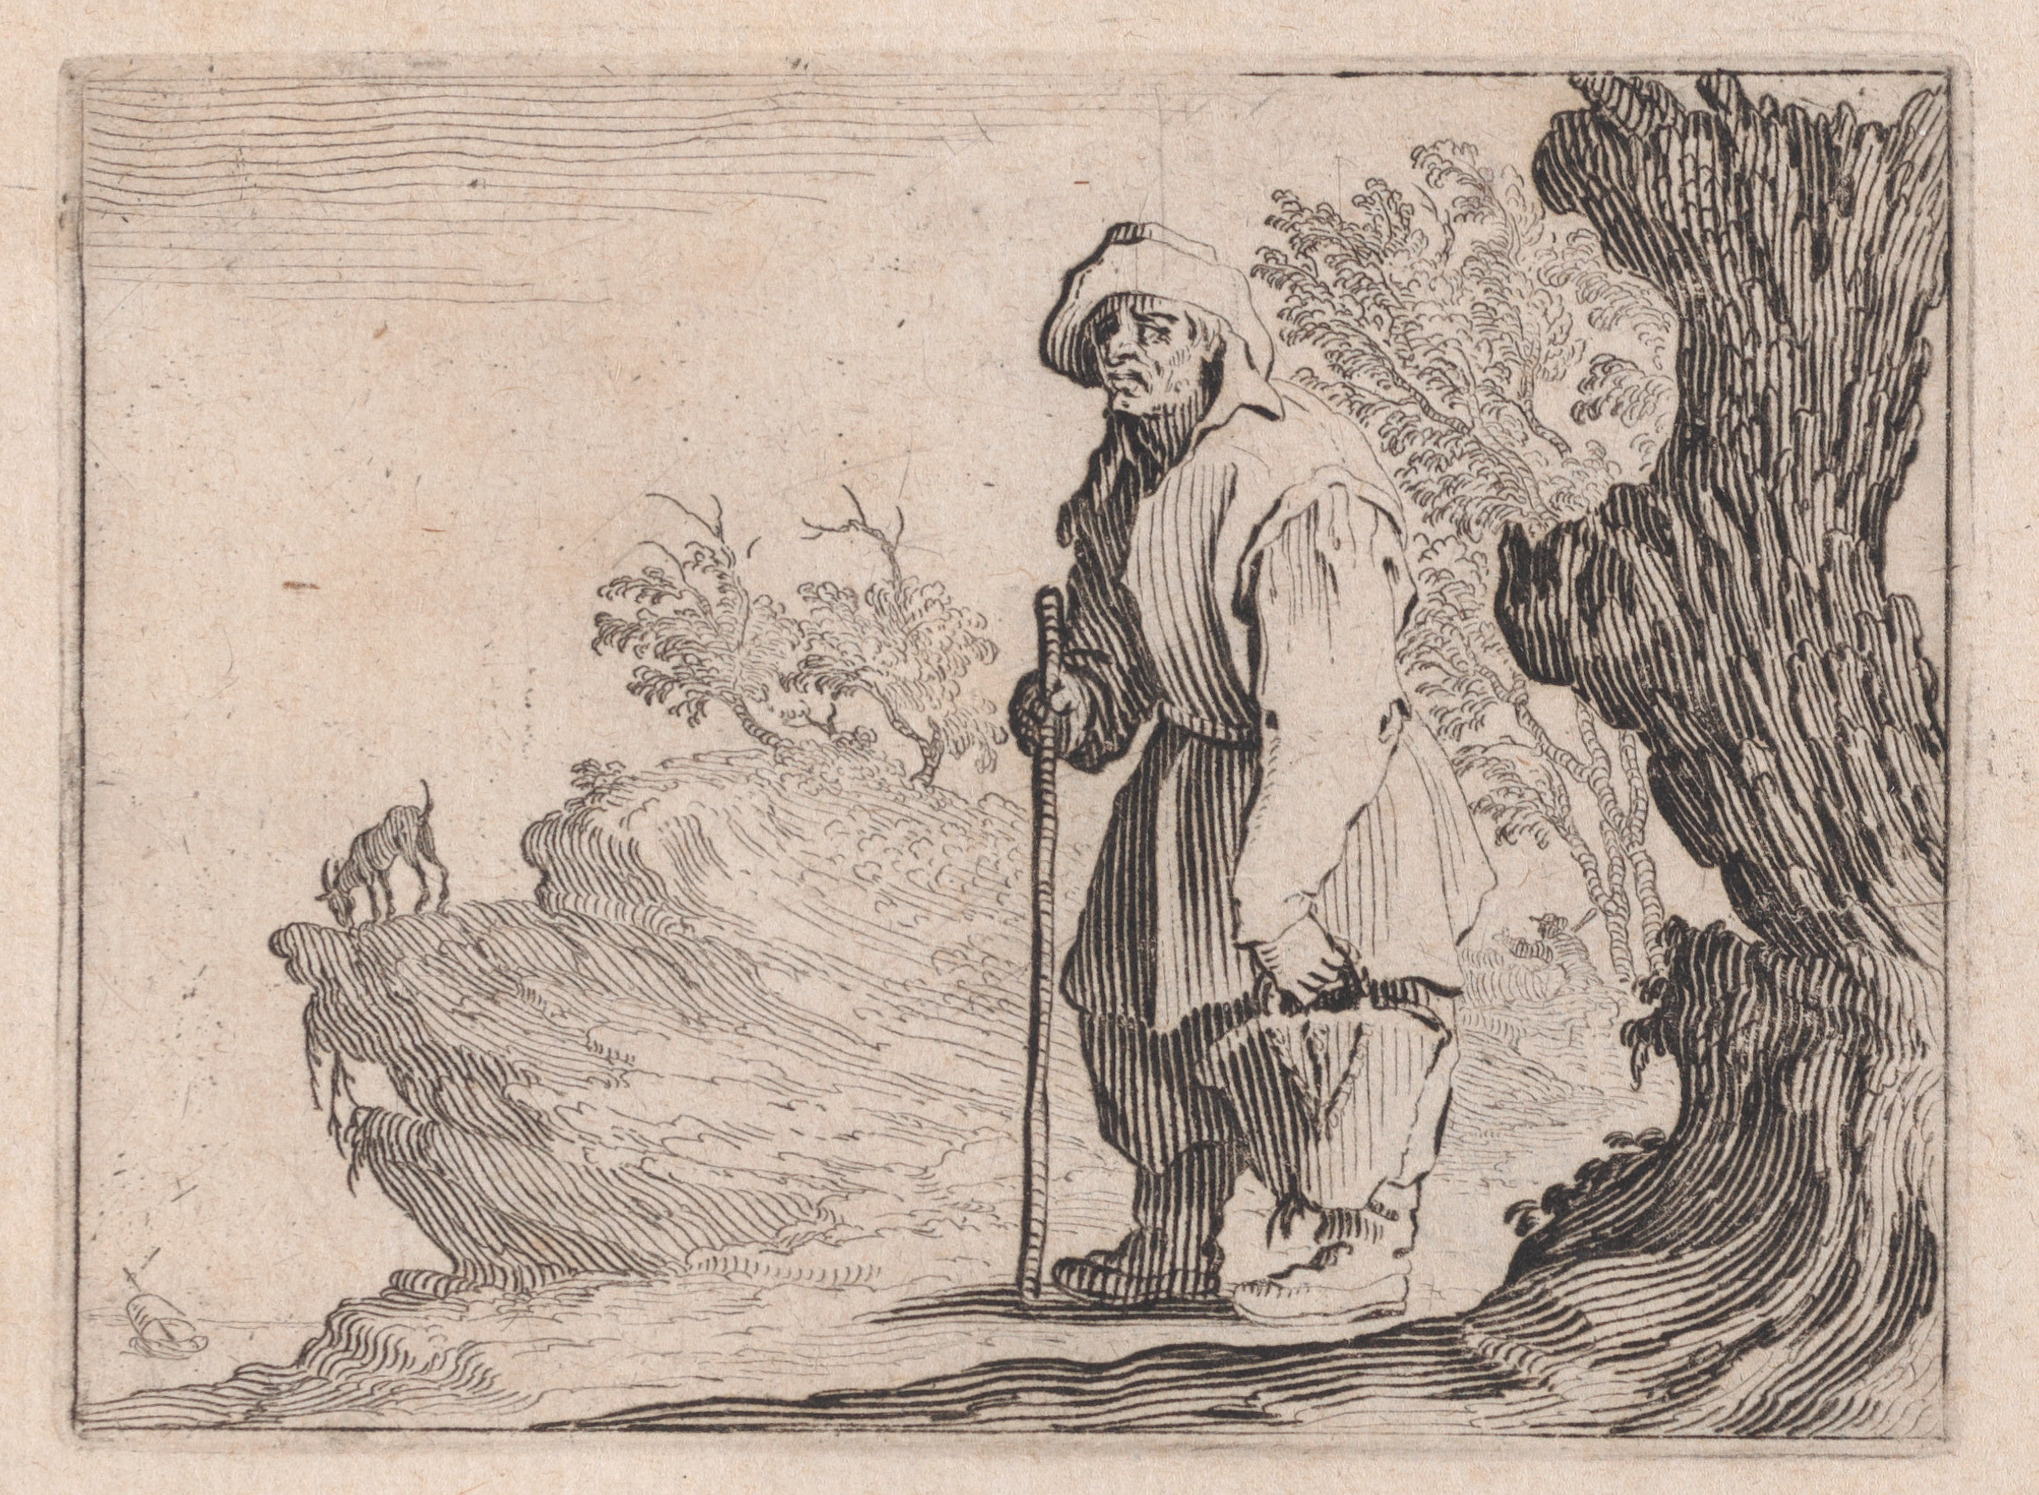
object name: print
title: Le Paysan Portant son Sac (The Peasant Carrying his Sack), from "Les Caprices" Series B, The Nancy Set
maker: jacques callot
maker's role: artist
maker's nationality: french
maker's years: 1592-1635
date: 1617-1620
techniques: etching